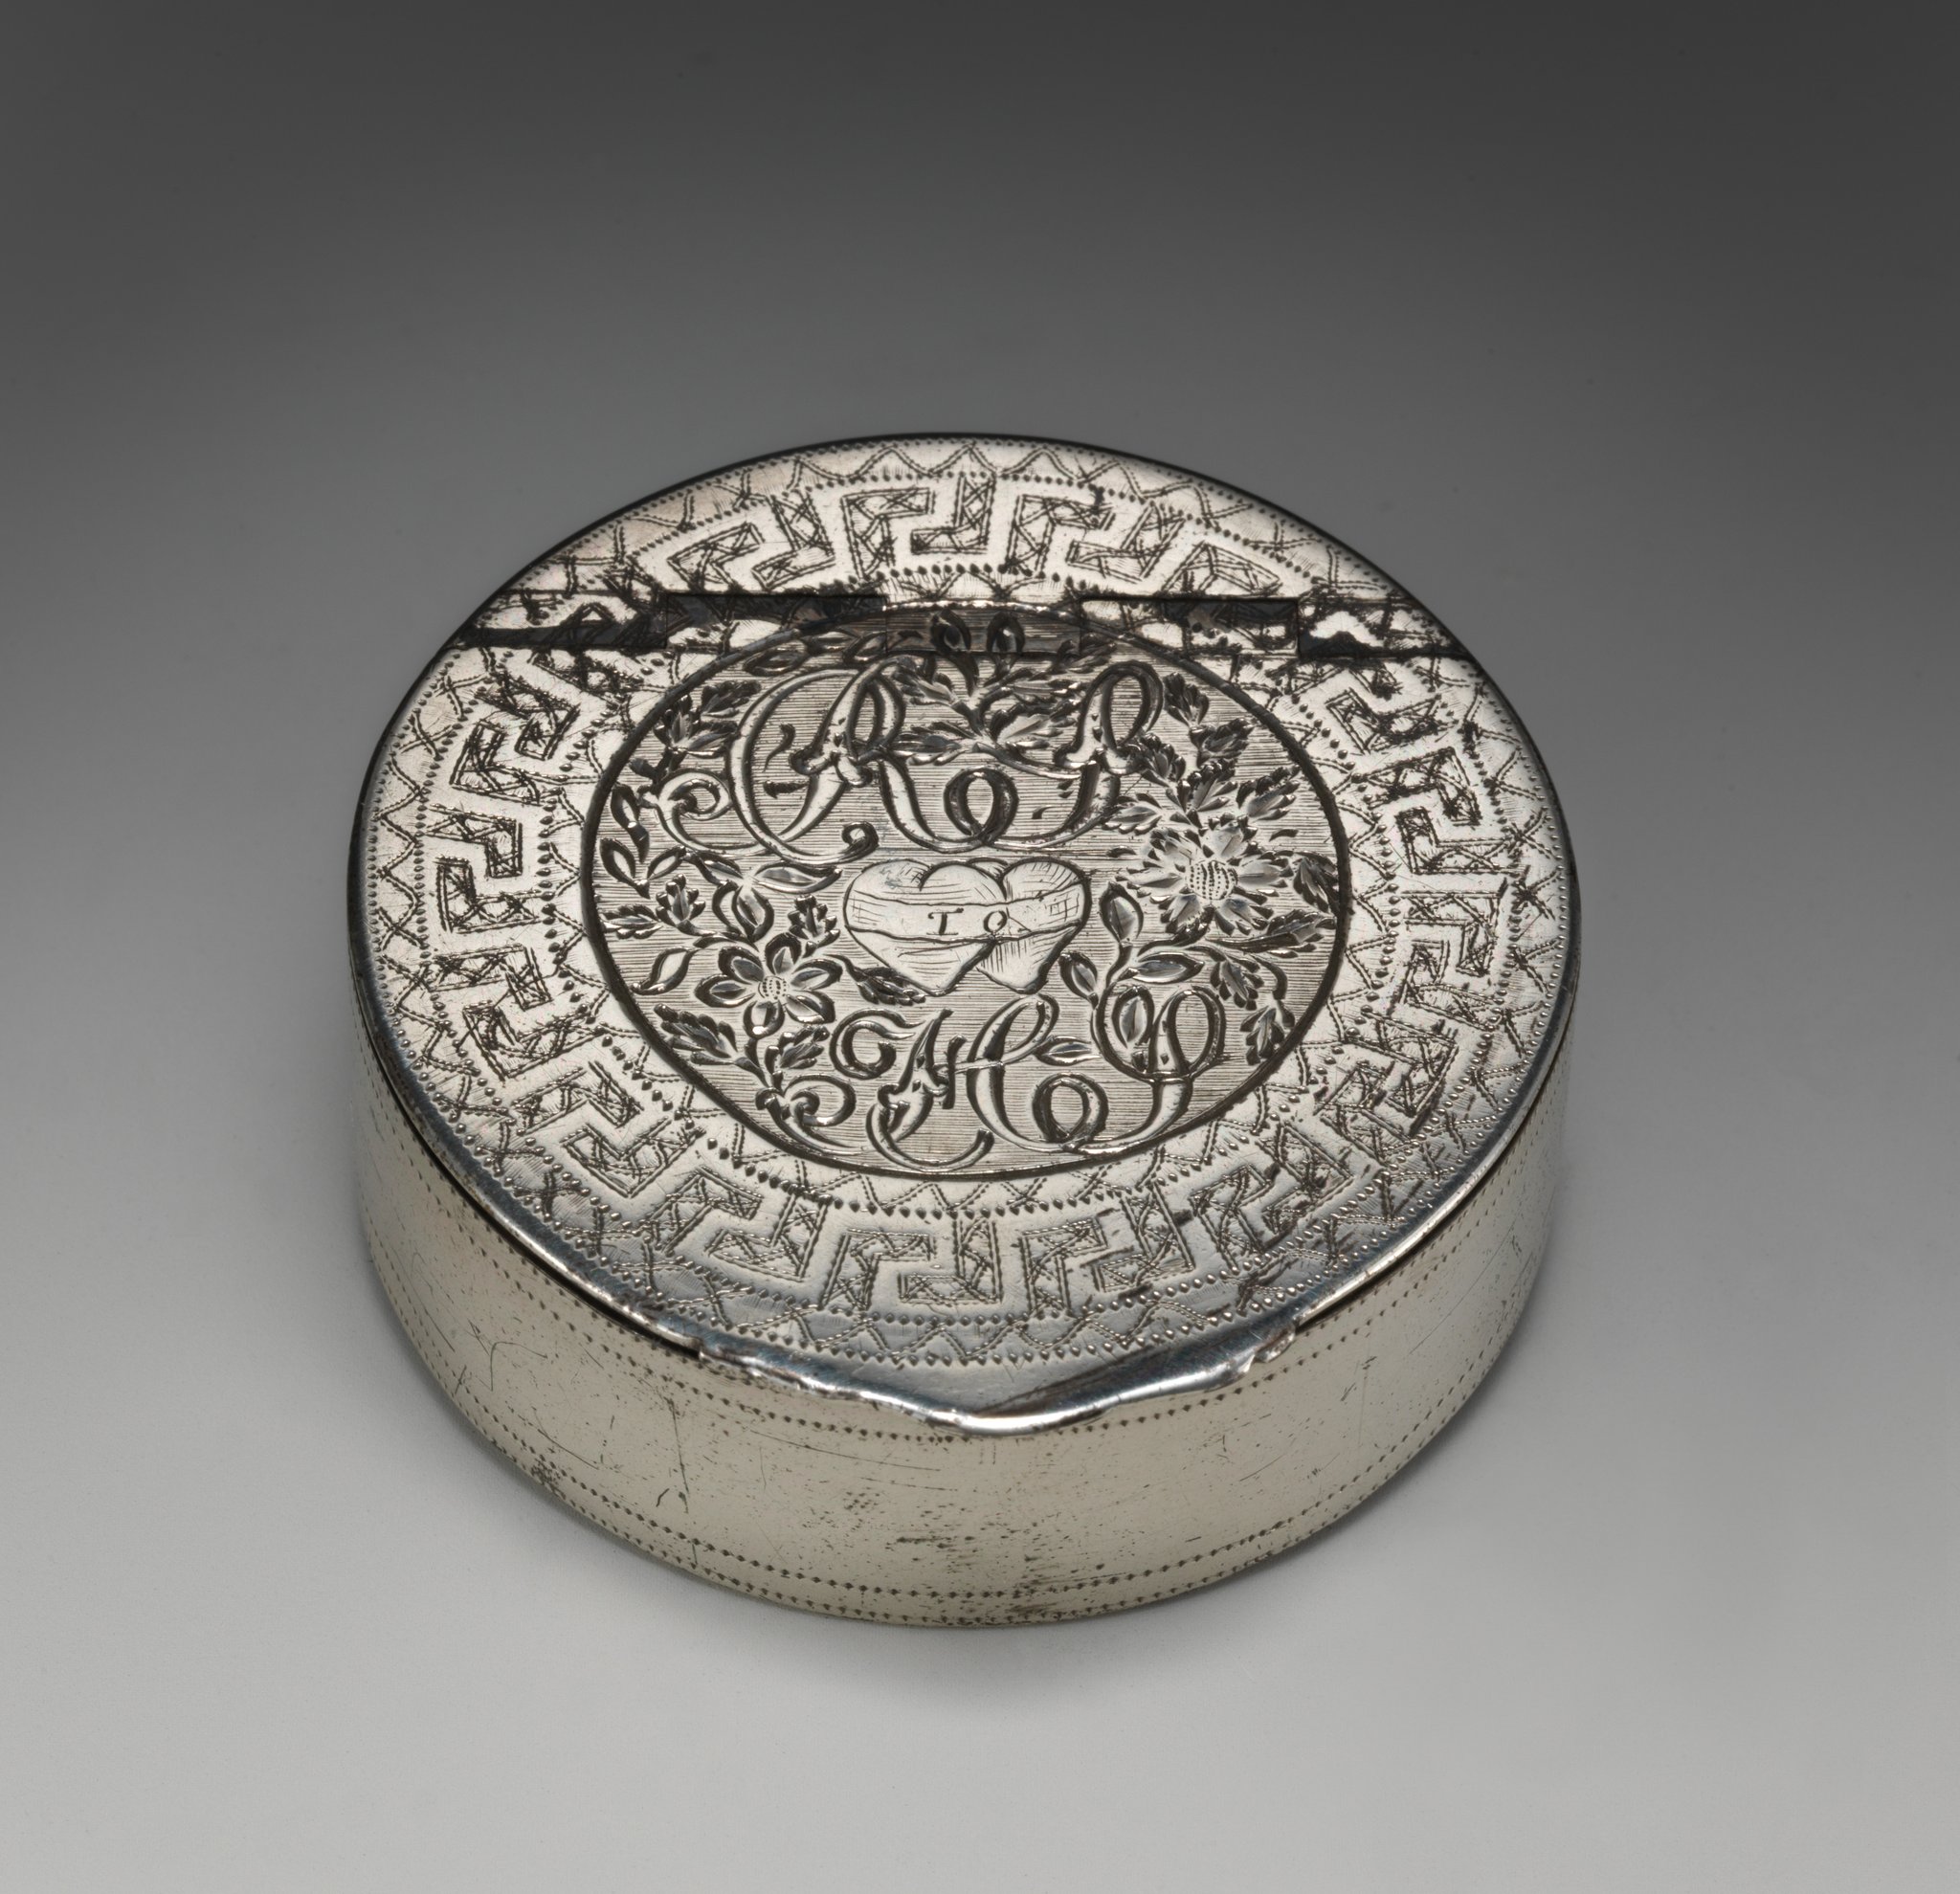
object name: snuffbox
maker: richard sawyer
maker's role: maker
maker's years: 1750-1850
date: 1806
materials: silver